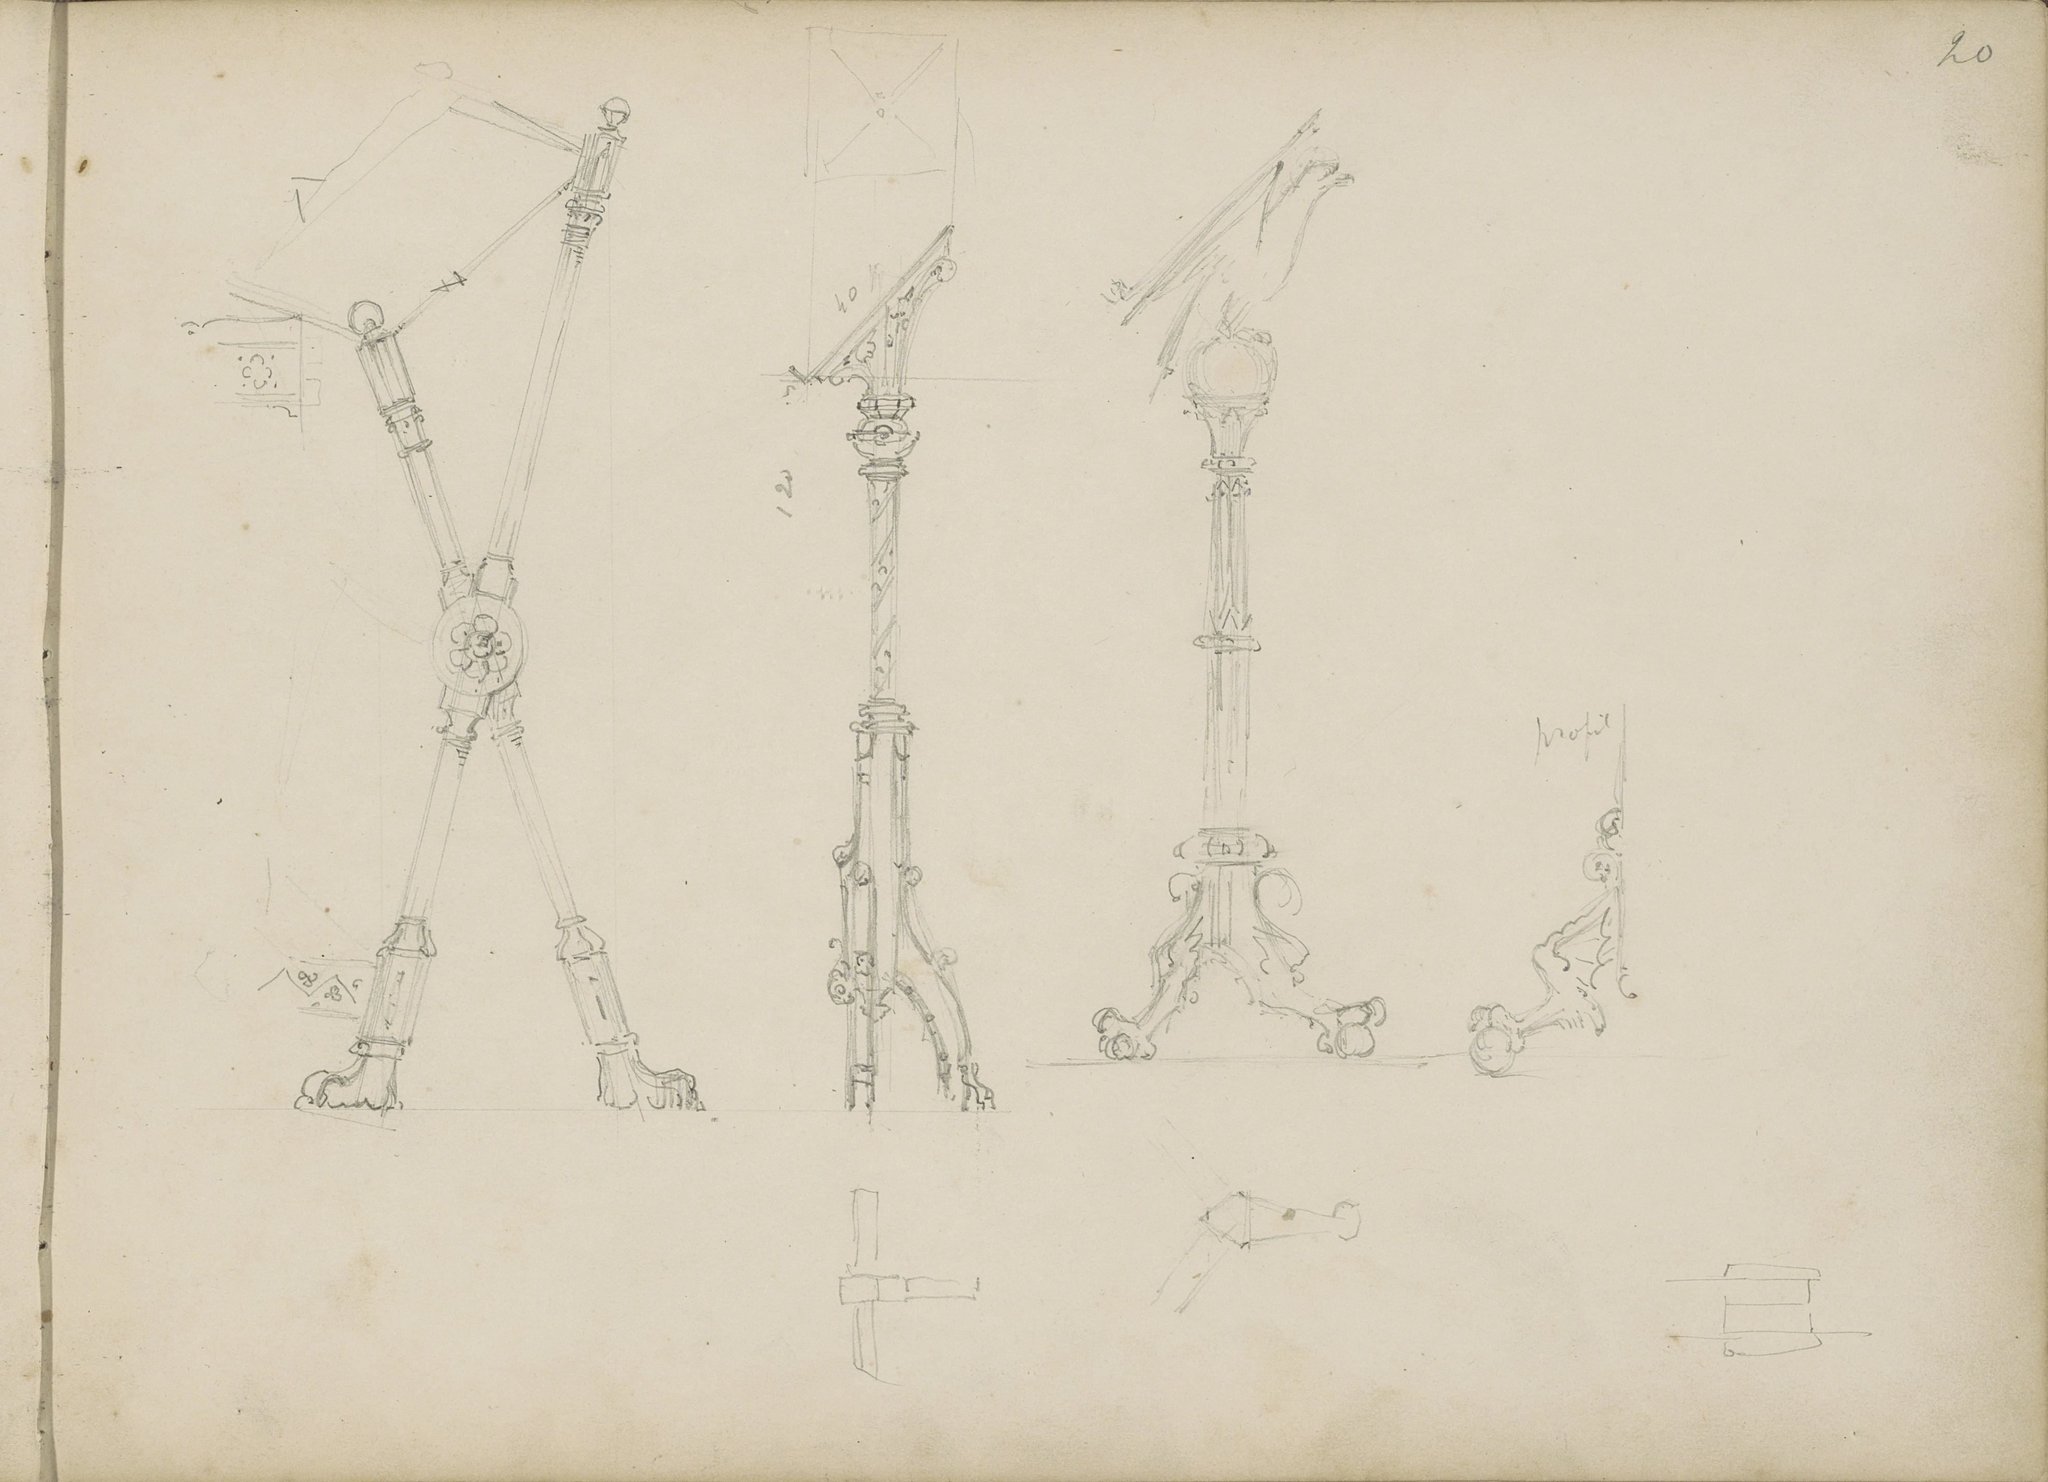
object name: sketchbook leaf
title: Lezenaars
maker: pierre joseph hubert cuypers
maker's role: draughtsman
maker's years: 1827-1921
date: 1857-1859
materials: paper, pencil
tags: lectern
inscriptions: annotation: ‘120/ 40/ profil’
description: Blad 20 recto uit een schetsboek met 77 bladen.